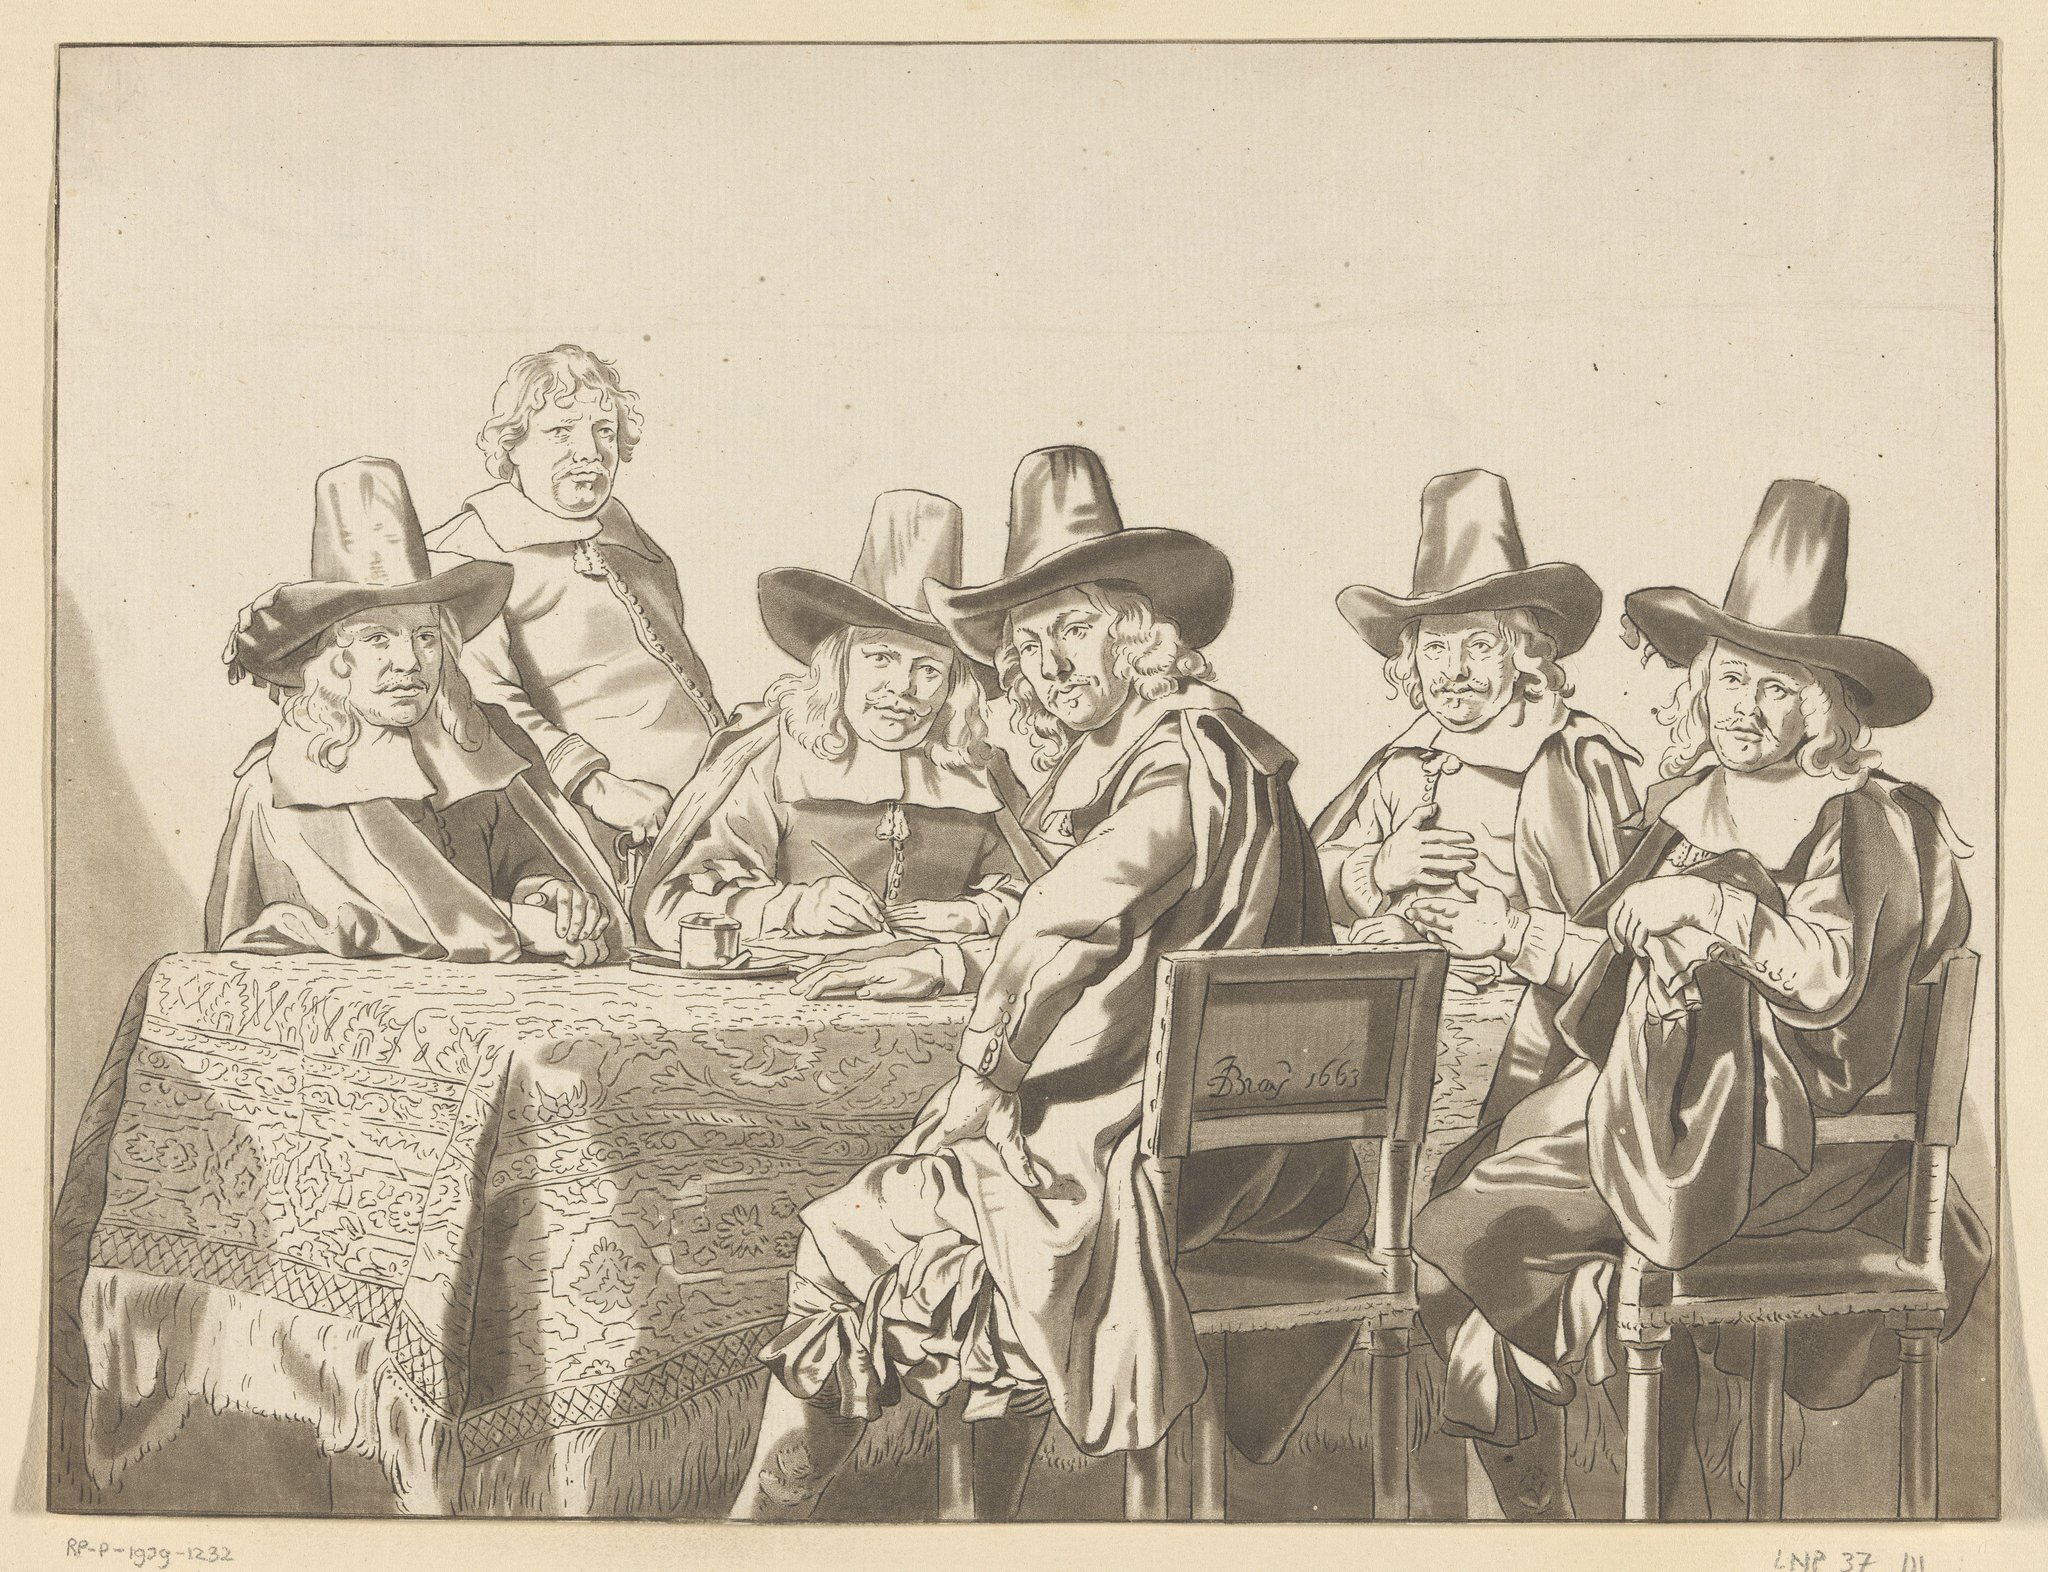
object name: print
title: Regenten van het weeshuis te Haarlem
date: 1777-1786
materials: paper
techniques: etching, roulette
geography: amsterdam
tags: table, board, esp. governors, trustees, etc. (dutch: 'regenten')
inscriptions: collector's mark: ‘RIJKS / MUSM’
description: De regenten van het weeshuis van Haarlem bijeen om een tafel. De bode staat op de achtergrond. De prent ligt los in een album, zie blad 37.